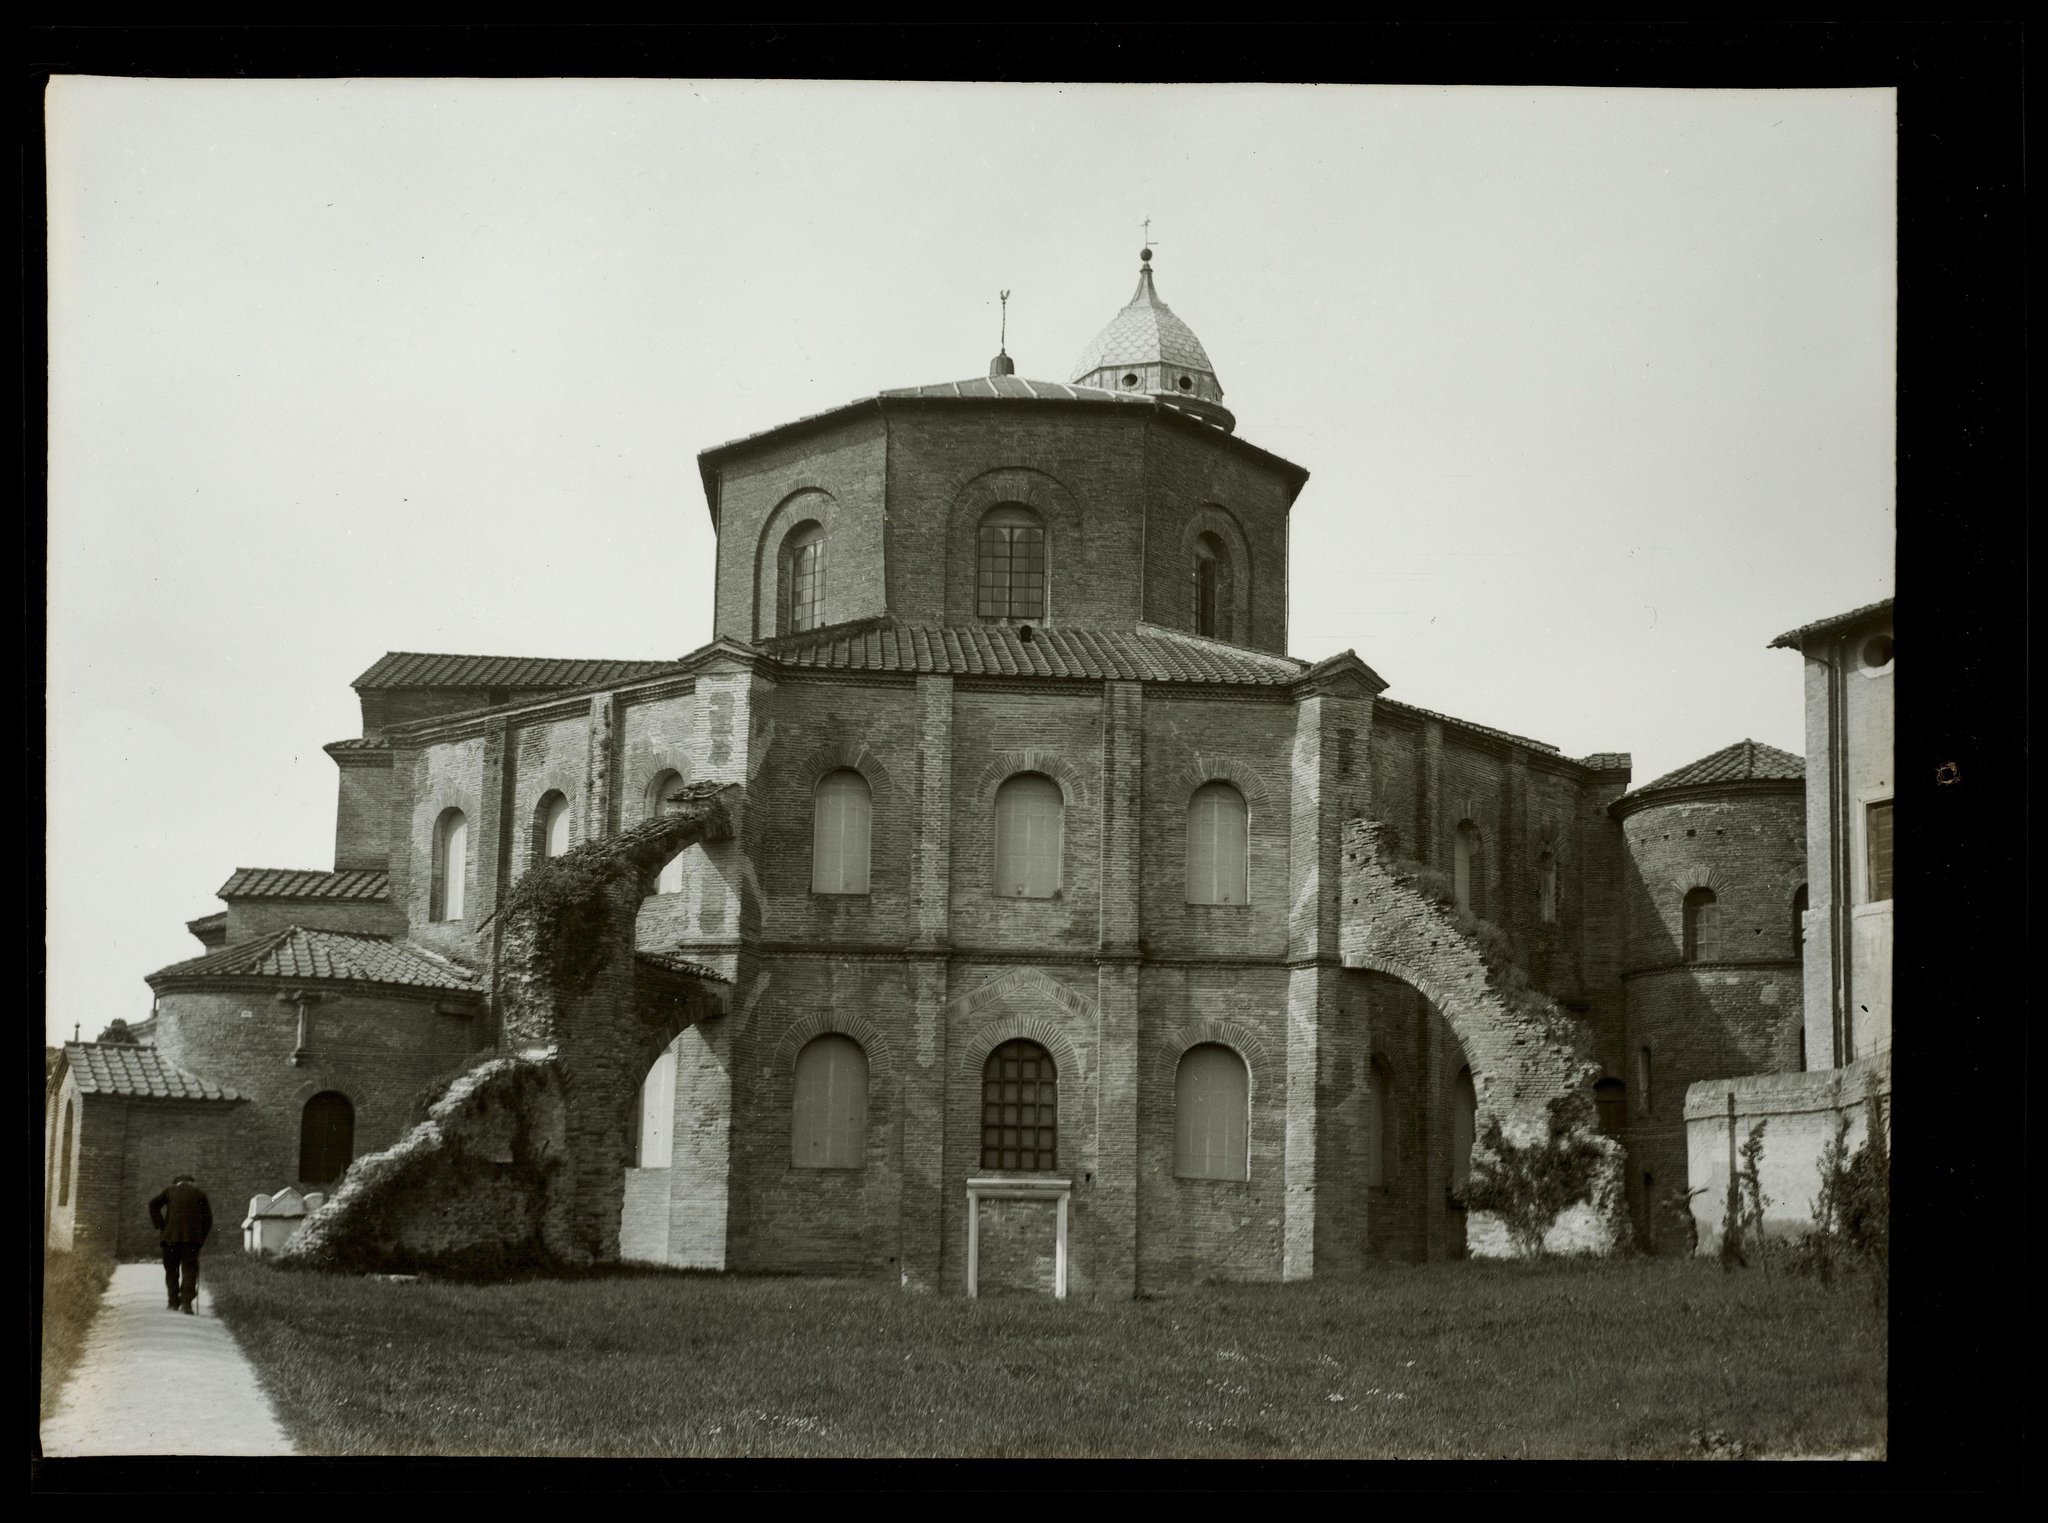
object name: negative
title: Filmnegatief met opname van Genua, Pisa, Ravenna of Milaan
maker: Anonymous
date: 1907-1935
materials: film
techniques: gelatin silver negative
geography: italy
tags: italy